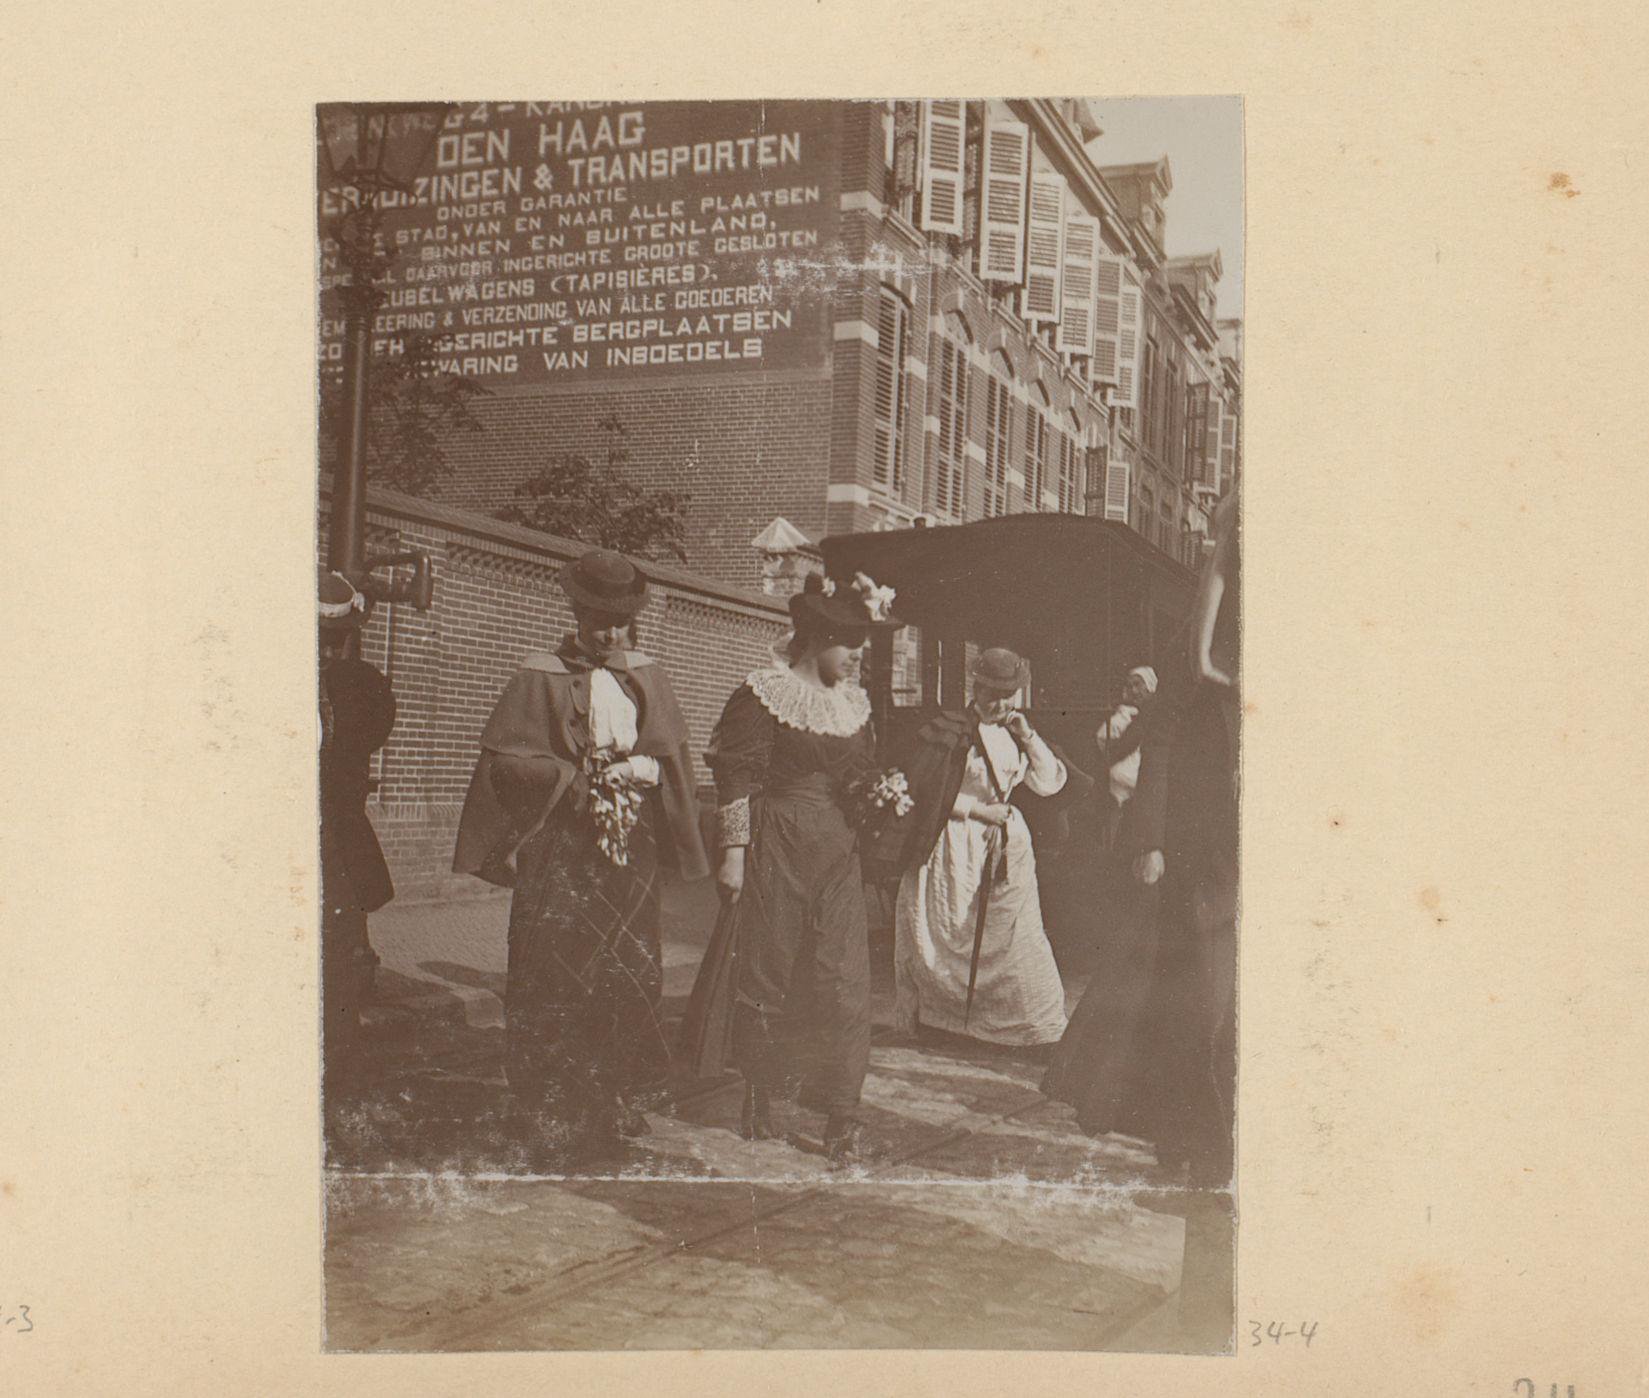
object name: photograph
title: Twee vrouwen op straat in Den Haag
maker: hendrik herman van den berg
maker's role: amateurfotograaf, jurist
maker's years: 1875-1944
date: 1890-1894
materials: paper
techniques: collodion silver print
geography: the hague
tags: historical persons - bb - woman, street, the hague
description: Foto 4 op albumblad 34 uit album "Amsterdam 1890-1894".